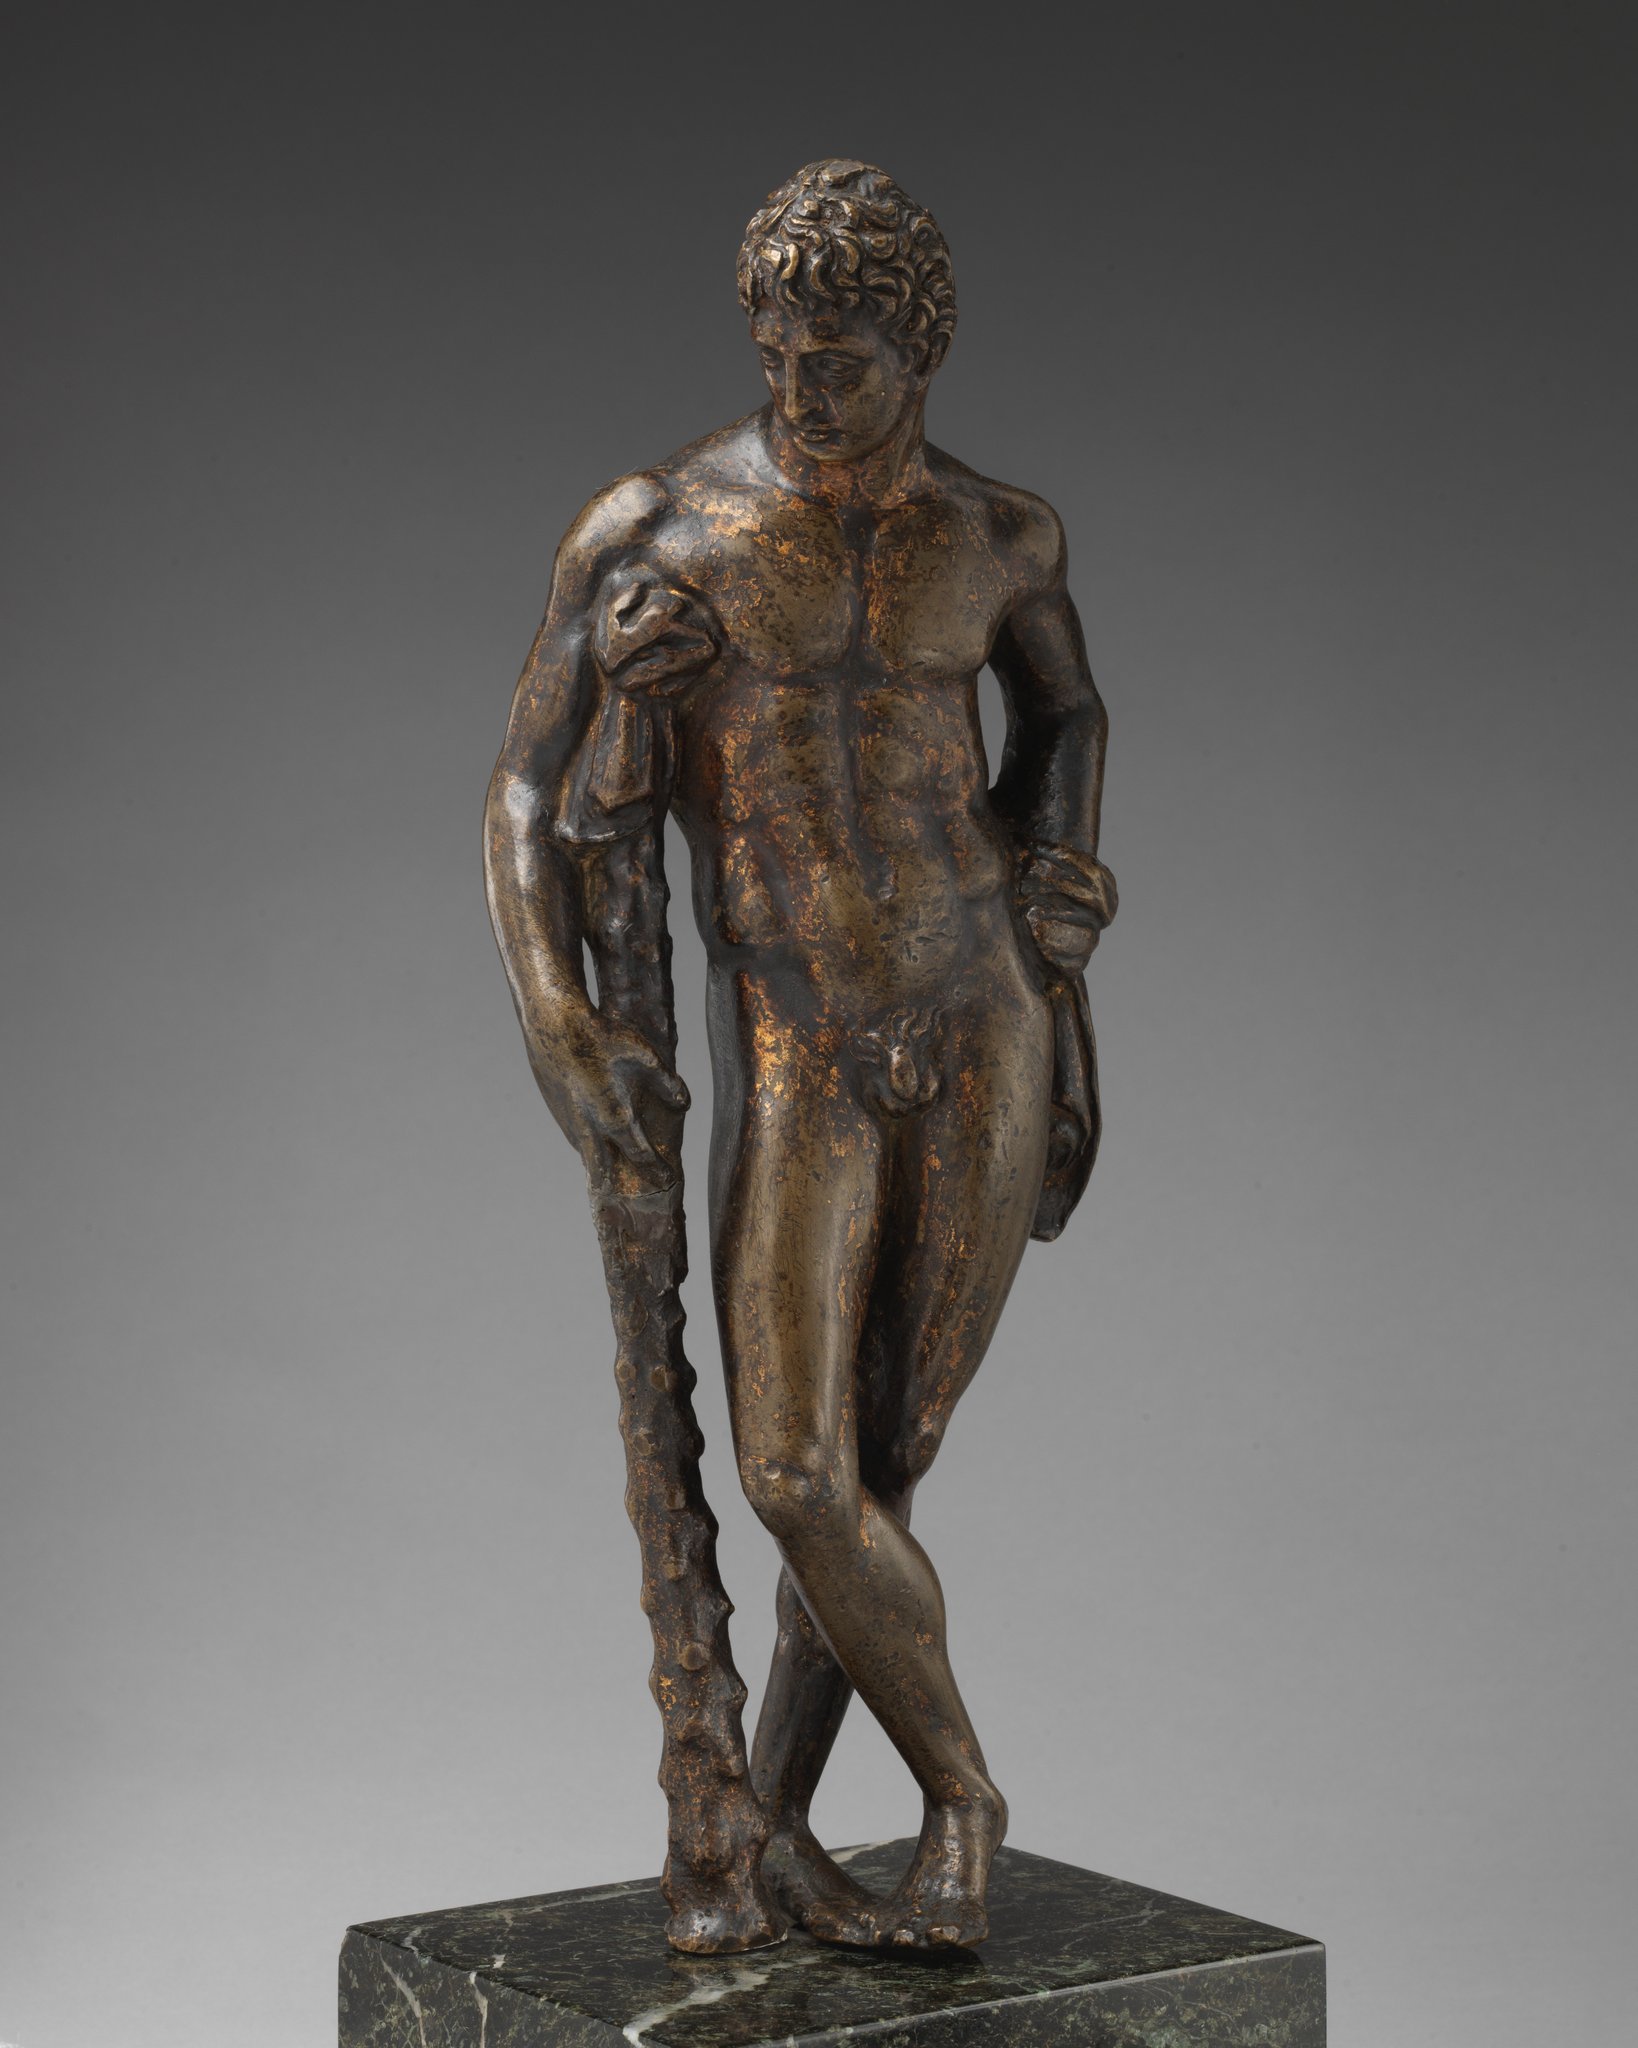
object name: statuette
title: Youthful Hercules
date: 1501-1600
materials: bronze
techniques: gilding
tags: male nudes,hercules